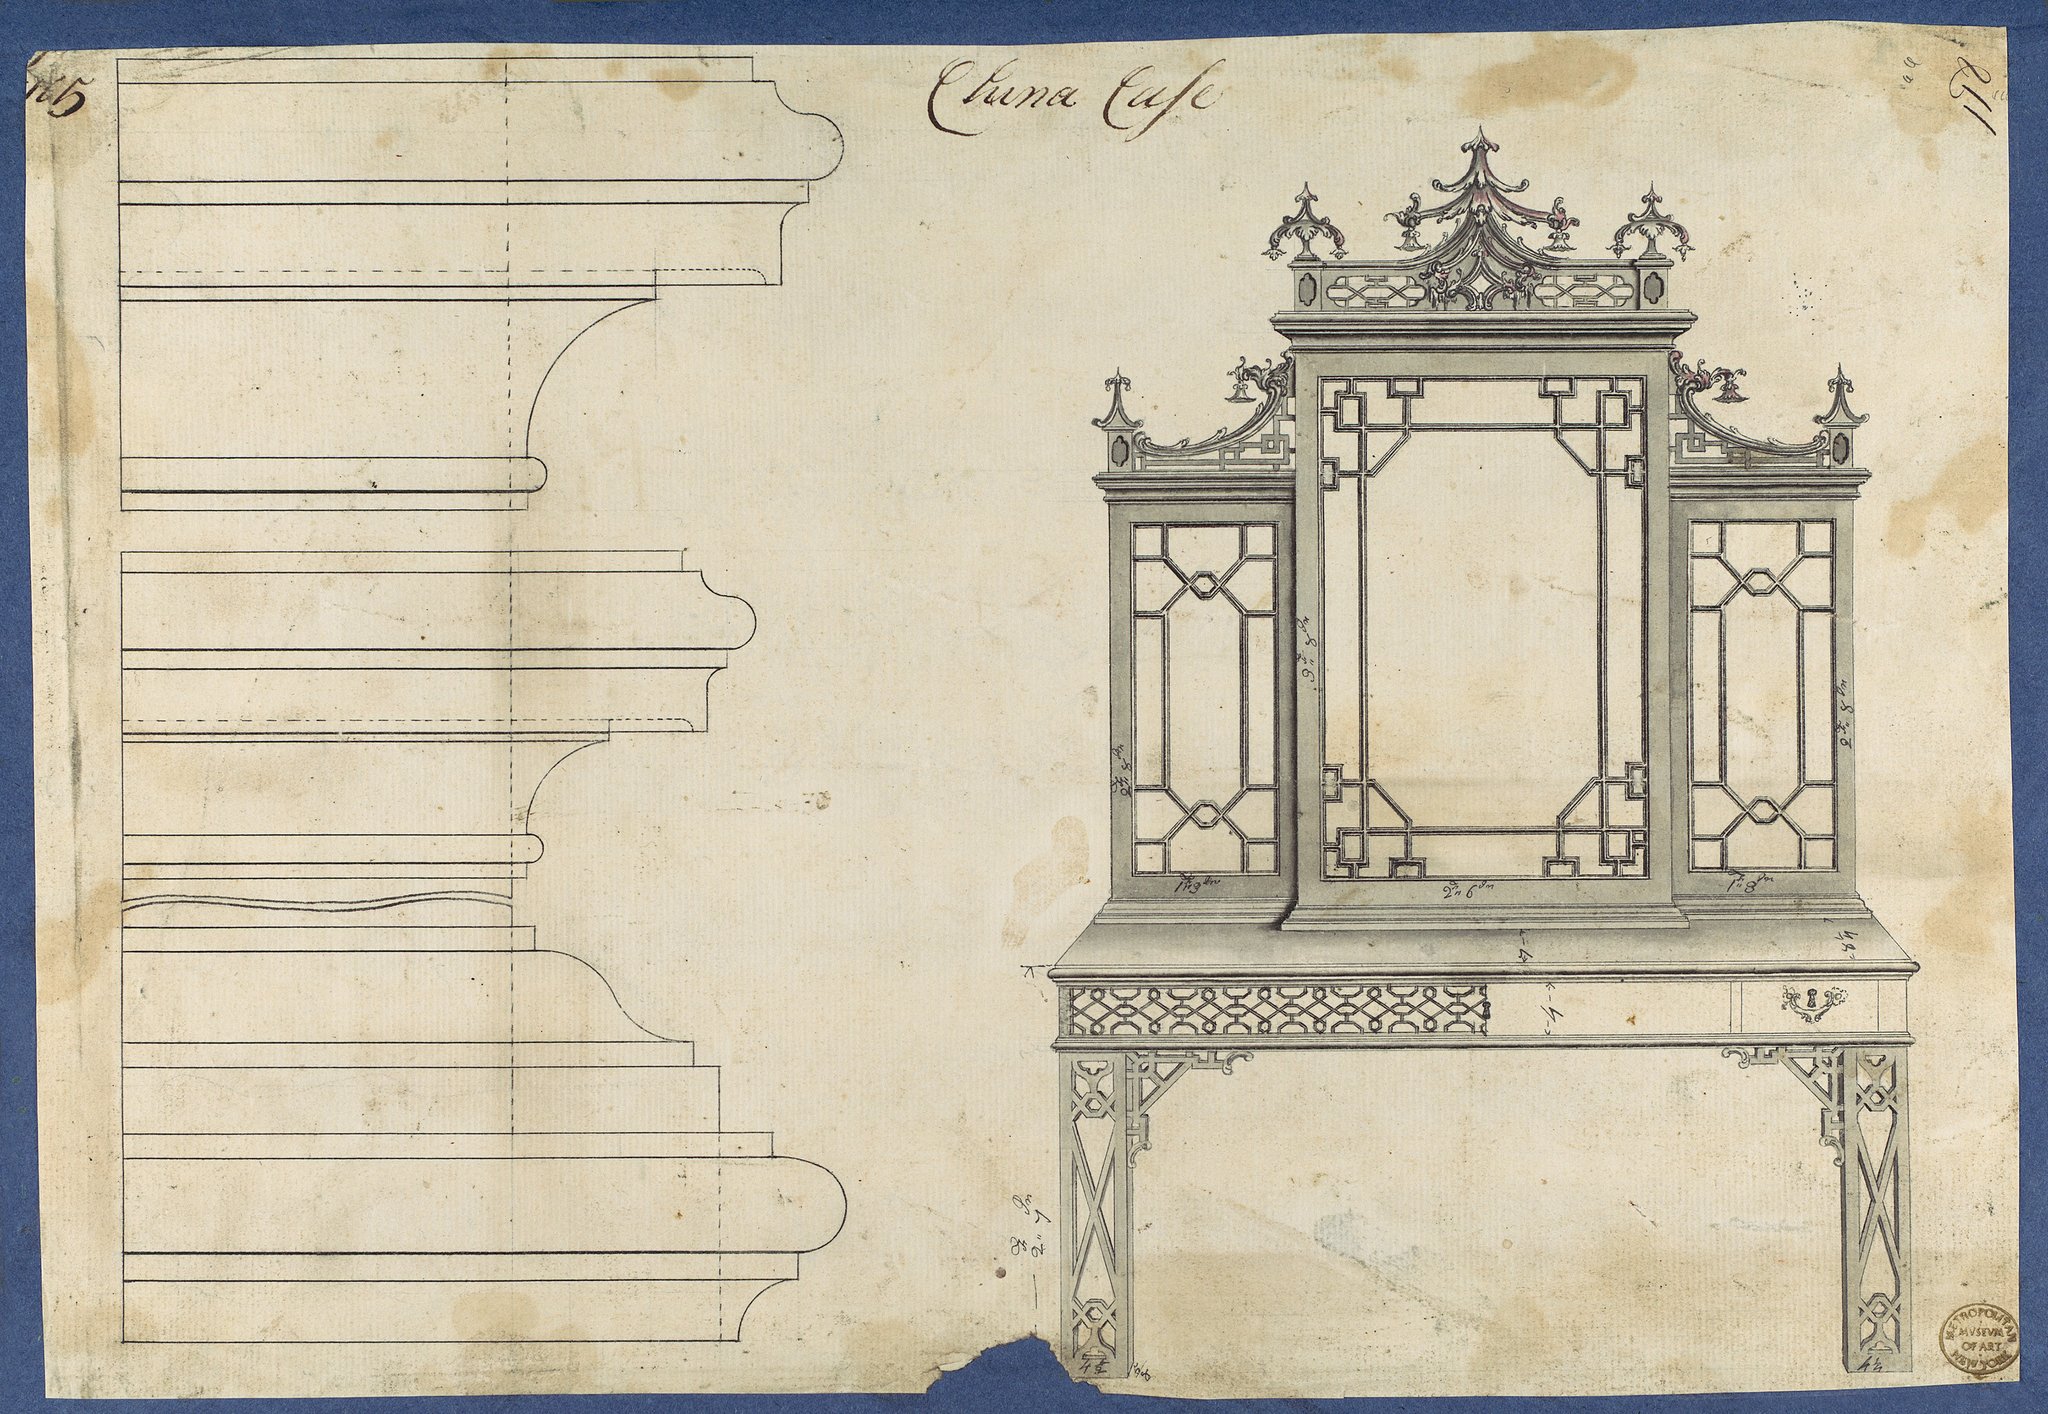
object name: drawing ornament architecture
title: China Case, from Chippendale Drawings, Vol. II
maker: thomas chippendale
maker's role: artist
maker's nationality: british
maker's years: 1718-1779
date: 1754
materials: ink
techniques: wash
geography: london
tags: furniture